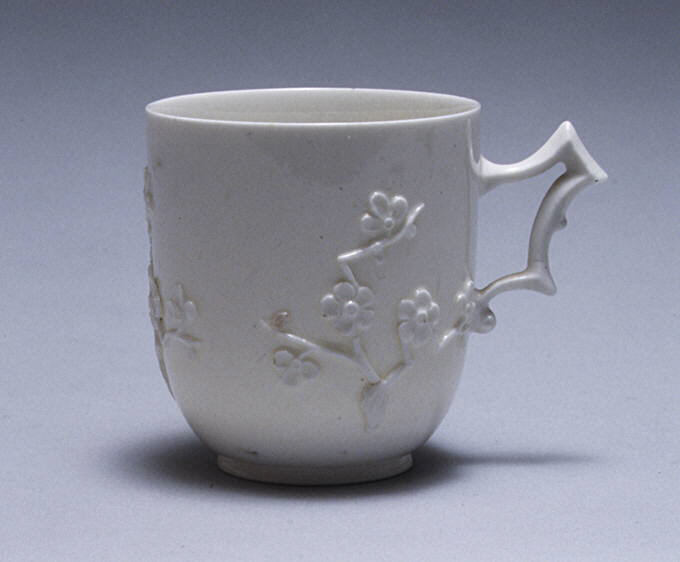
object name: cup and saucer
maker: capodimonte porcelain manufactory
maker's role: manufactory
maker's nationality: italian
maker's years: 1740-1759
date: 1745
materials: soft paste porcelain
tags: flowers